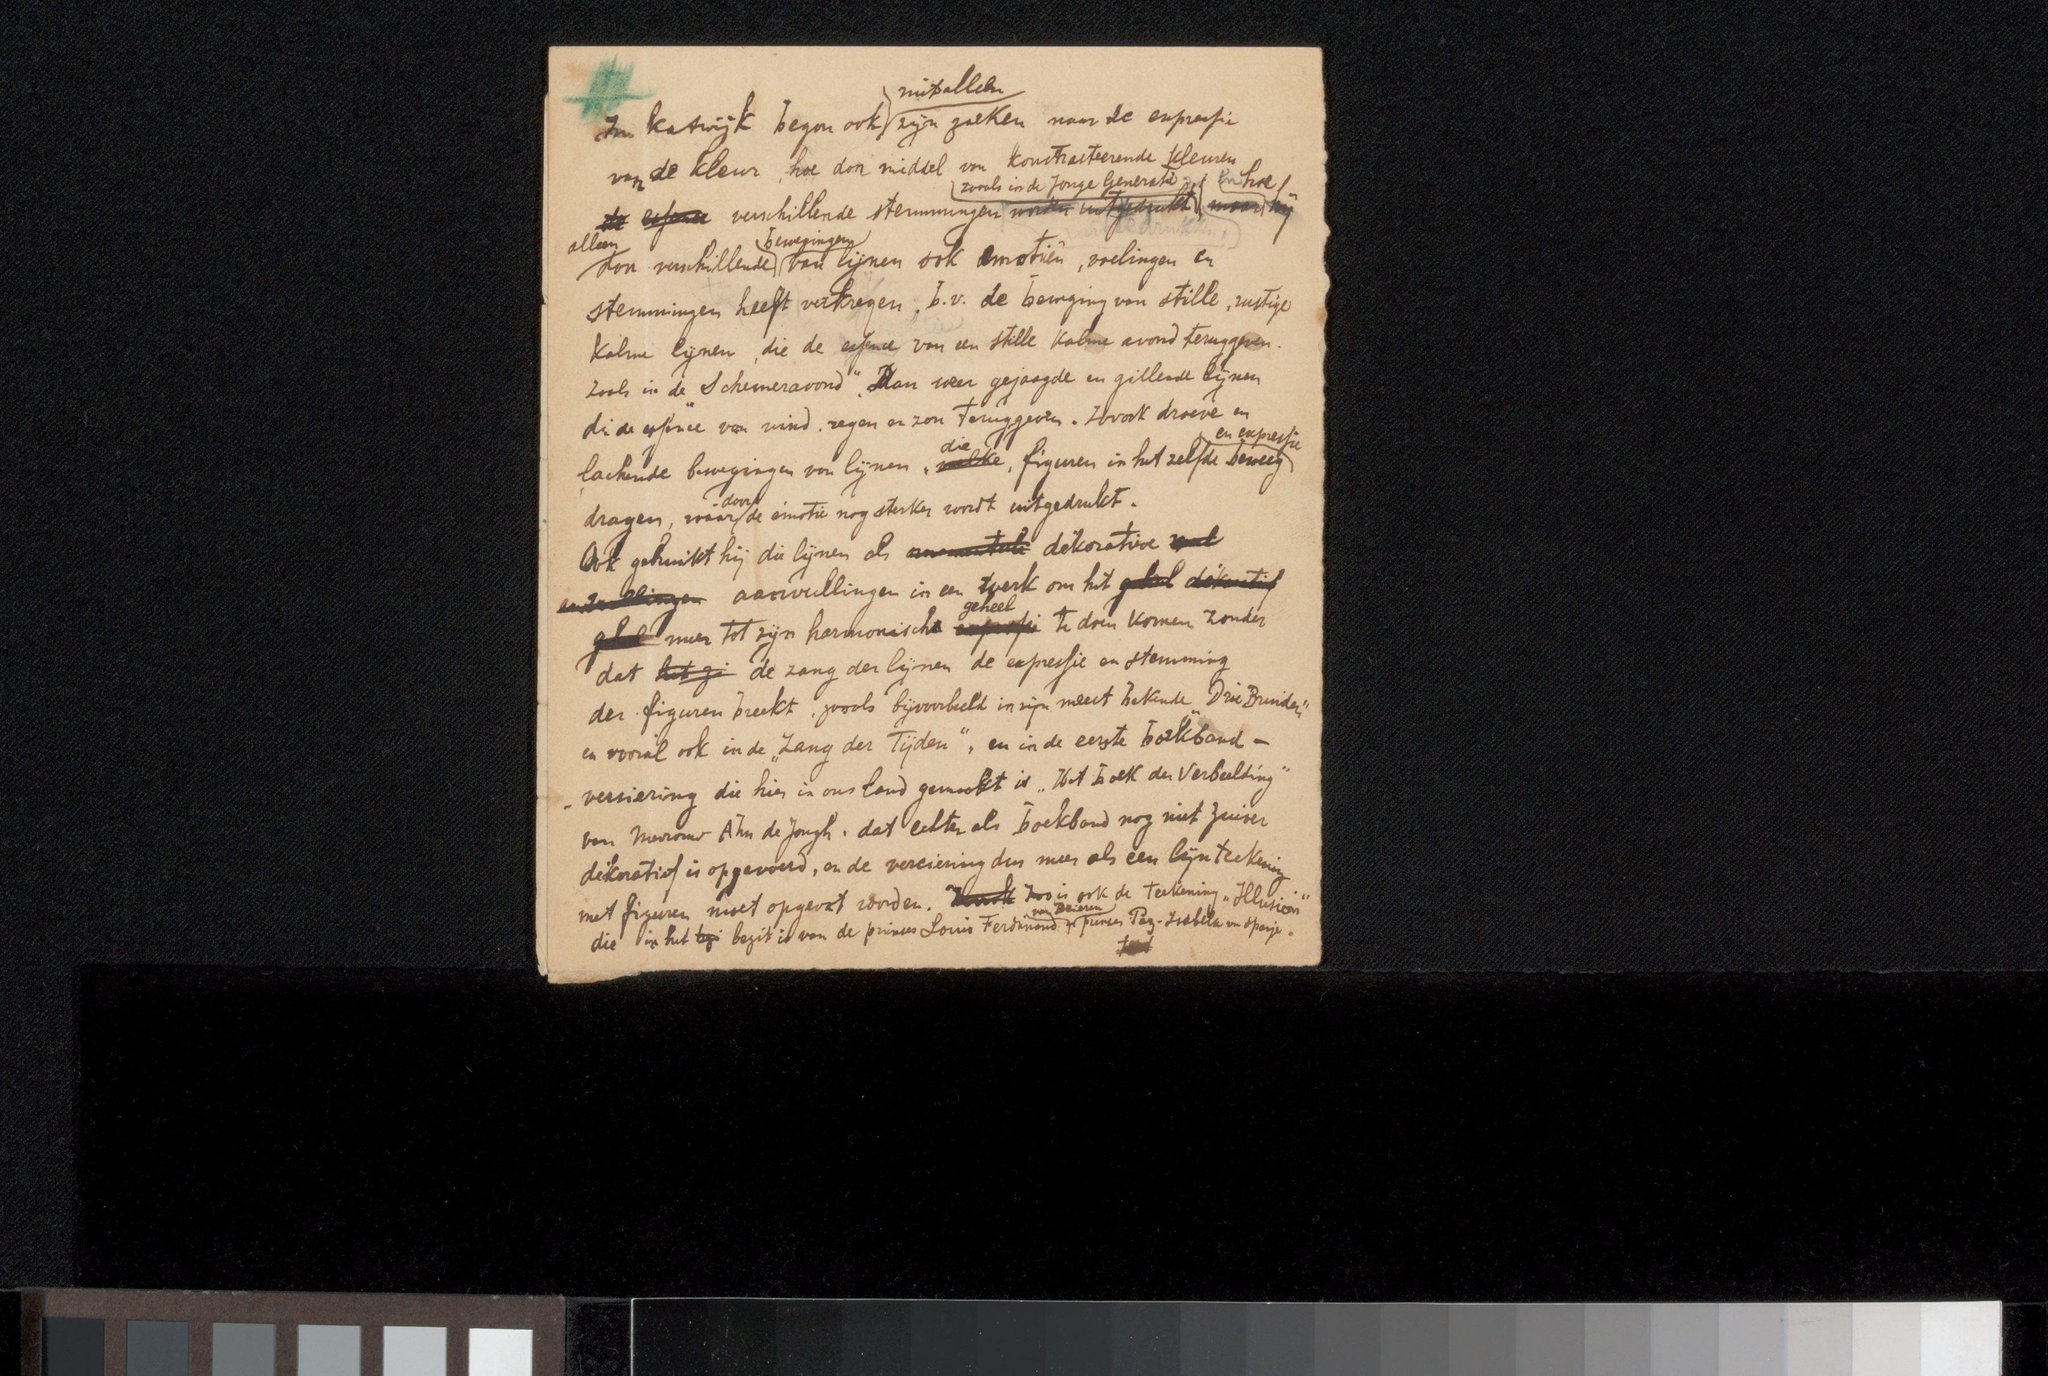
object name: aantekening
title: Aantekening uit archief Philip Zilcken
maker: jan toorop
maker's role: draughtsman, painter, print maker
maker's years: 1858-1928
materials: chalk, ink, paper, pencil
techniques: pen, writing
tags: philip zilcken, drawing, illustration ~ printed matter, book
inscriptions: collector's mark: ‘RPK’